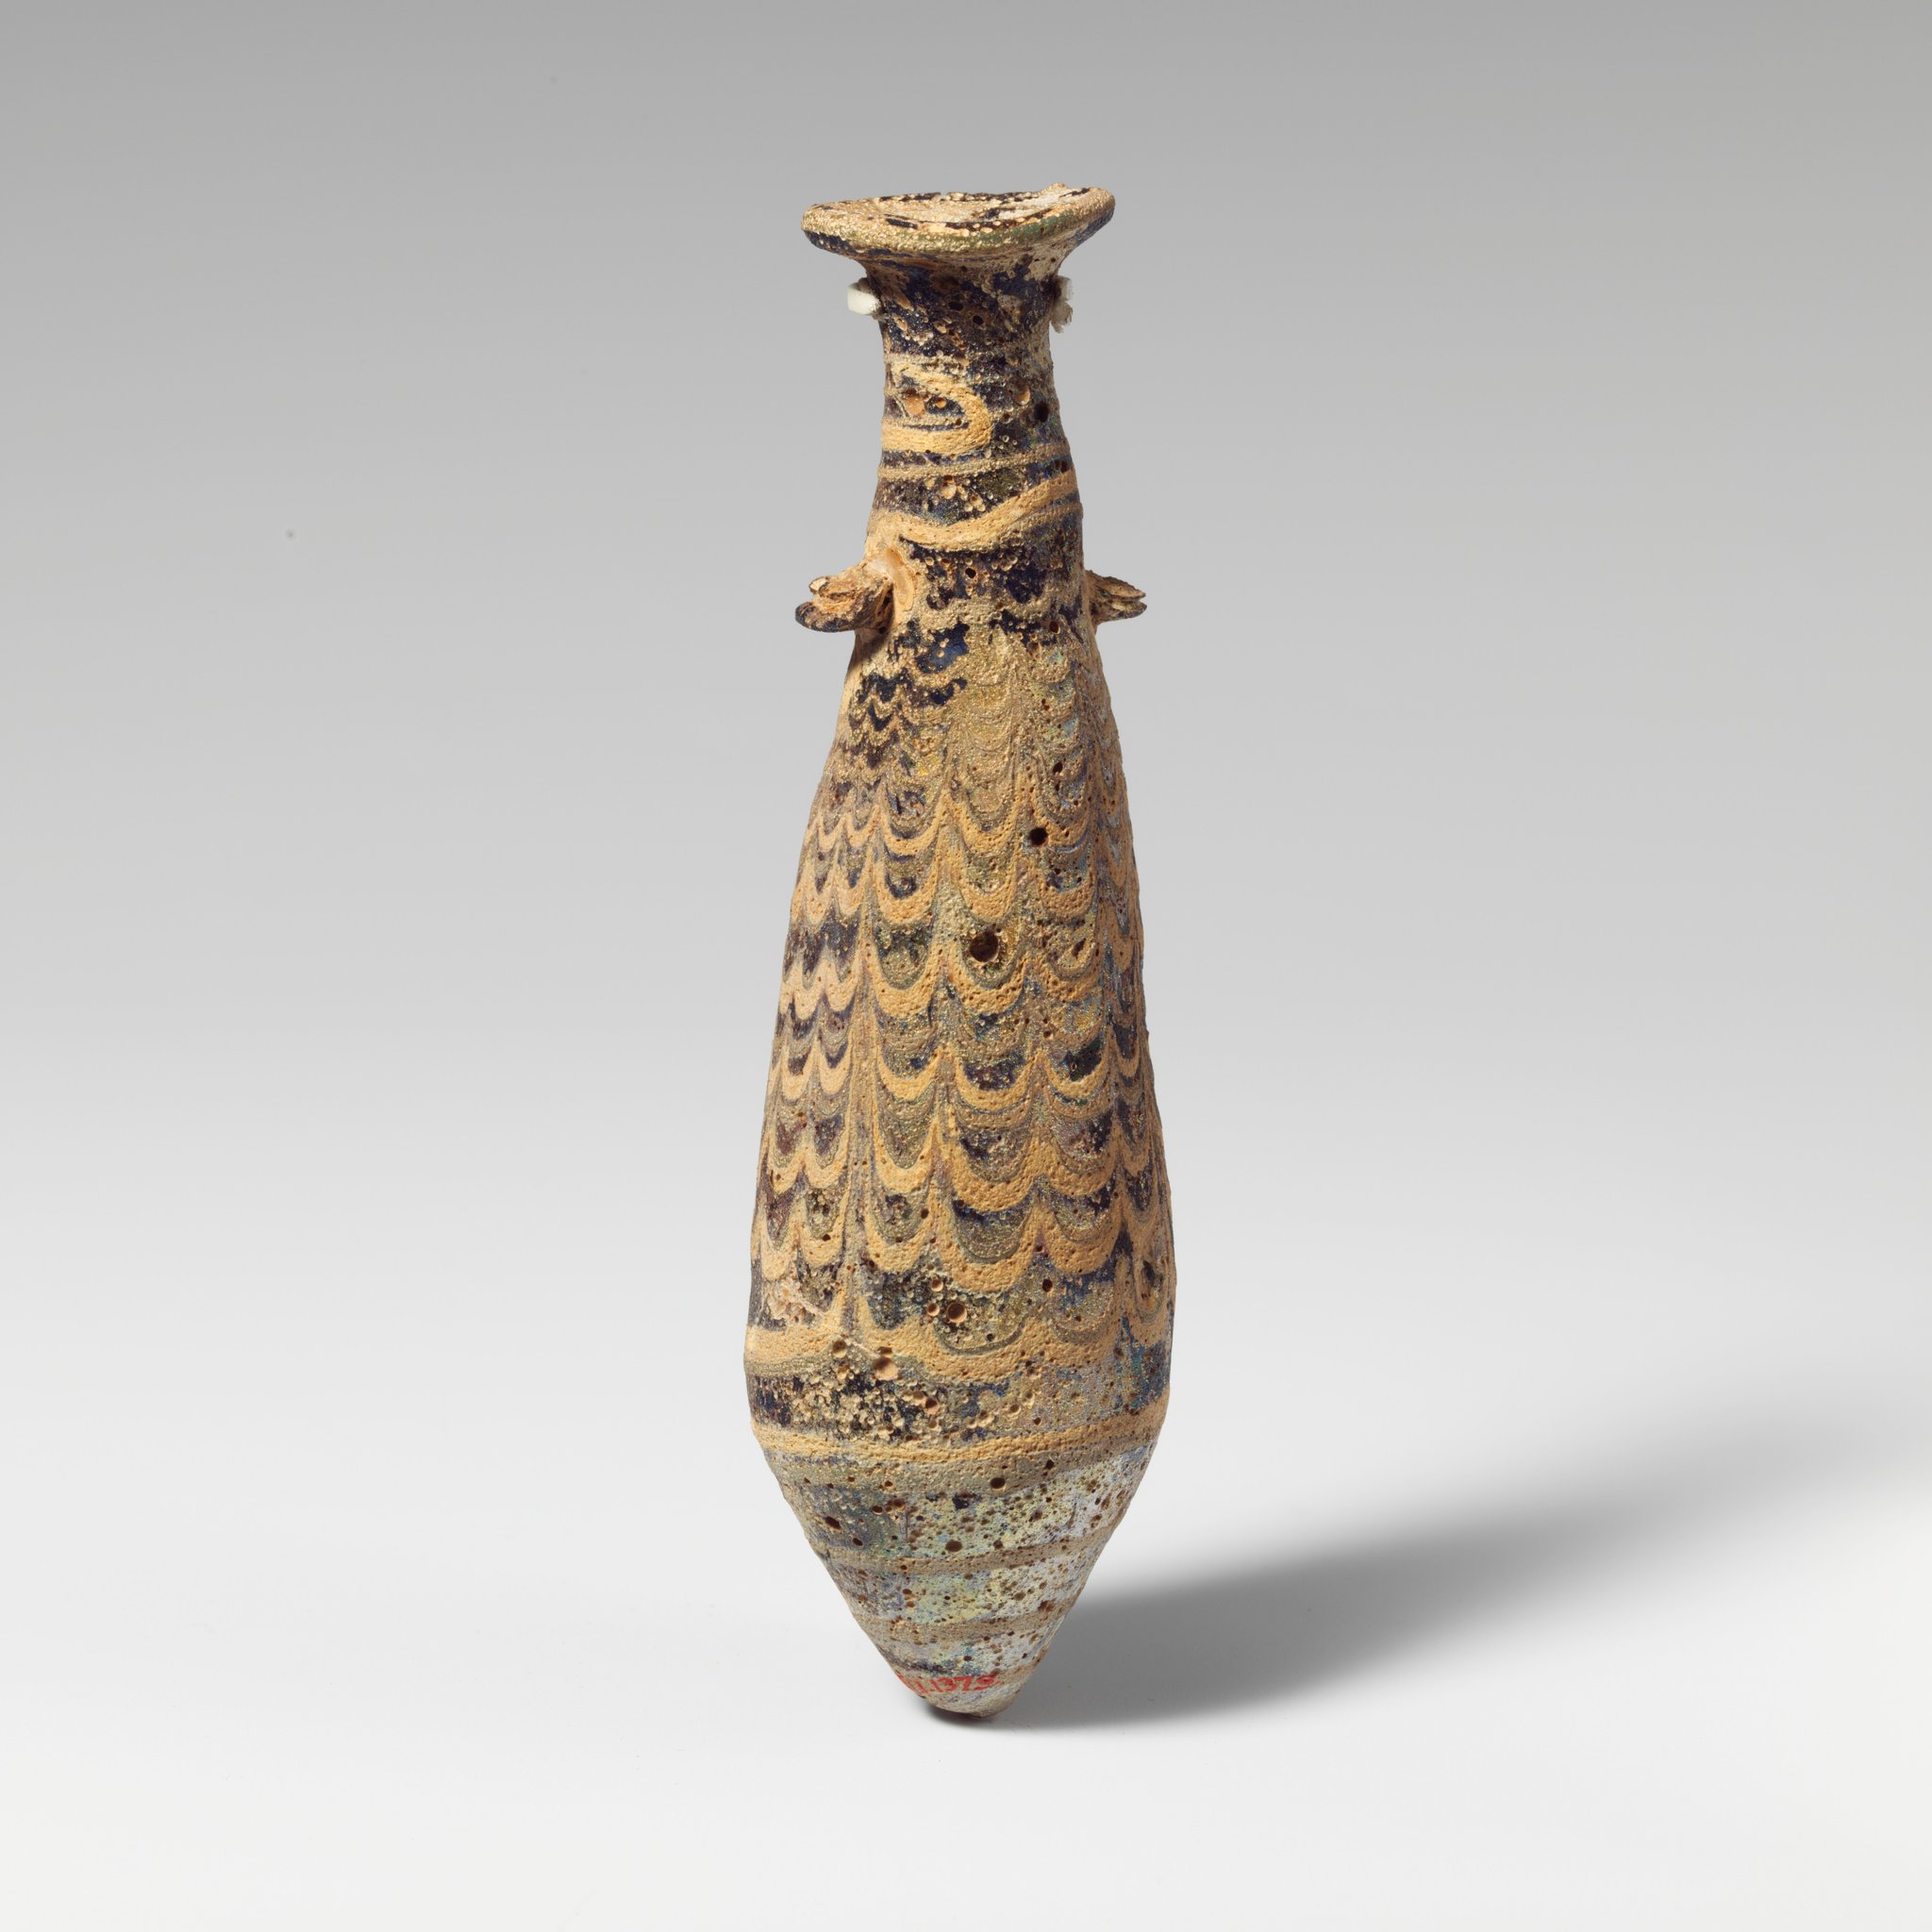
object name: alabastron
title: Glass alabastron (perfume bottle)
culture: greek, eastern mediterranean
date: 200-35 BCE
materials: glass